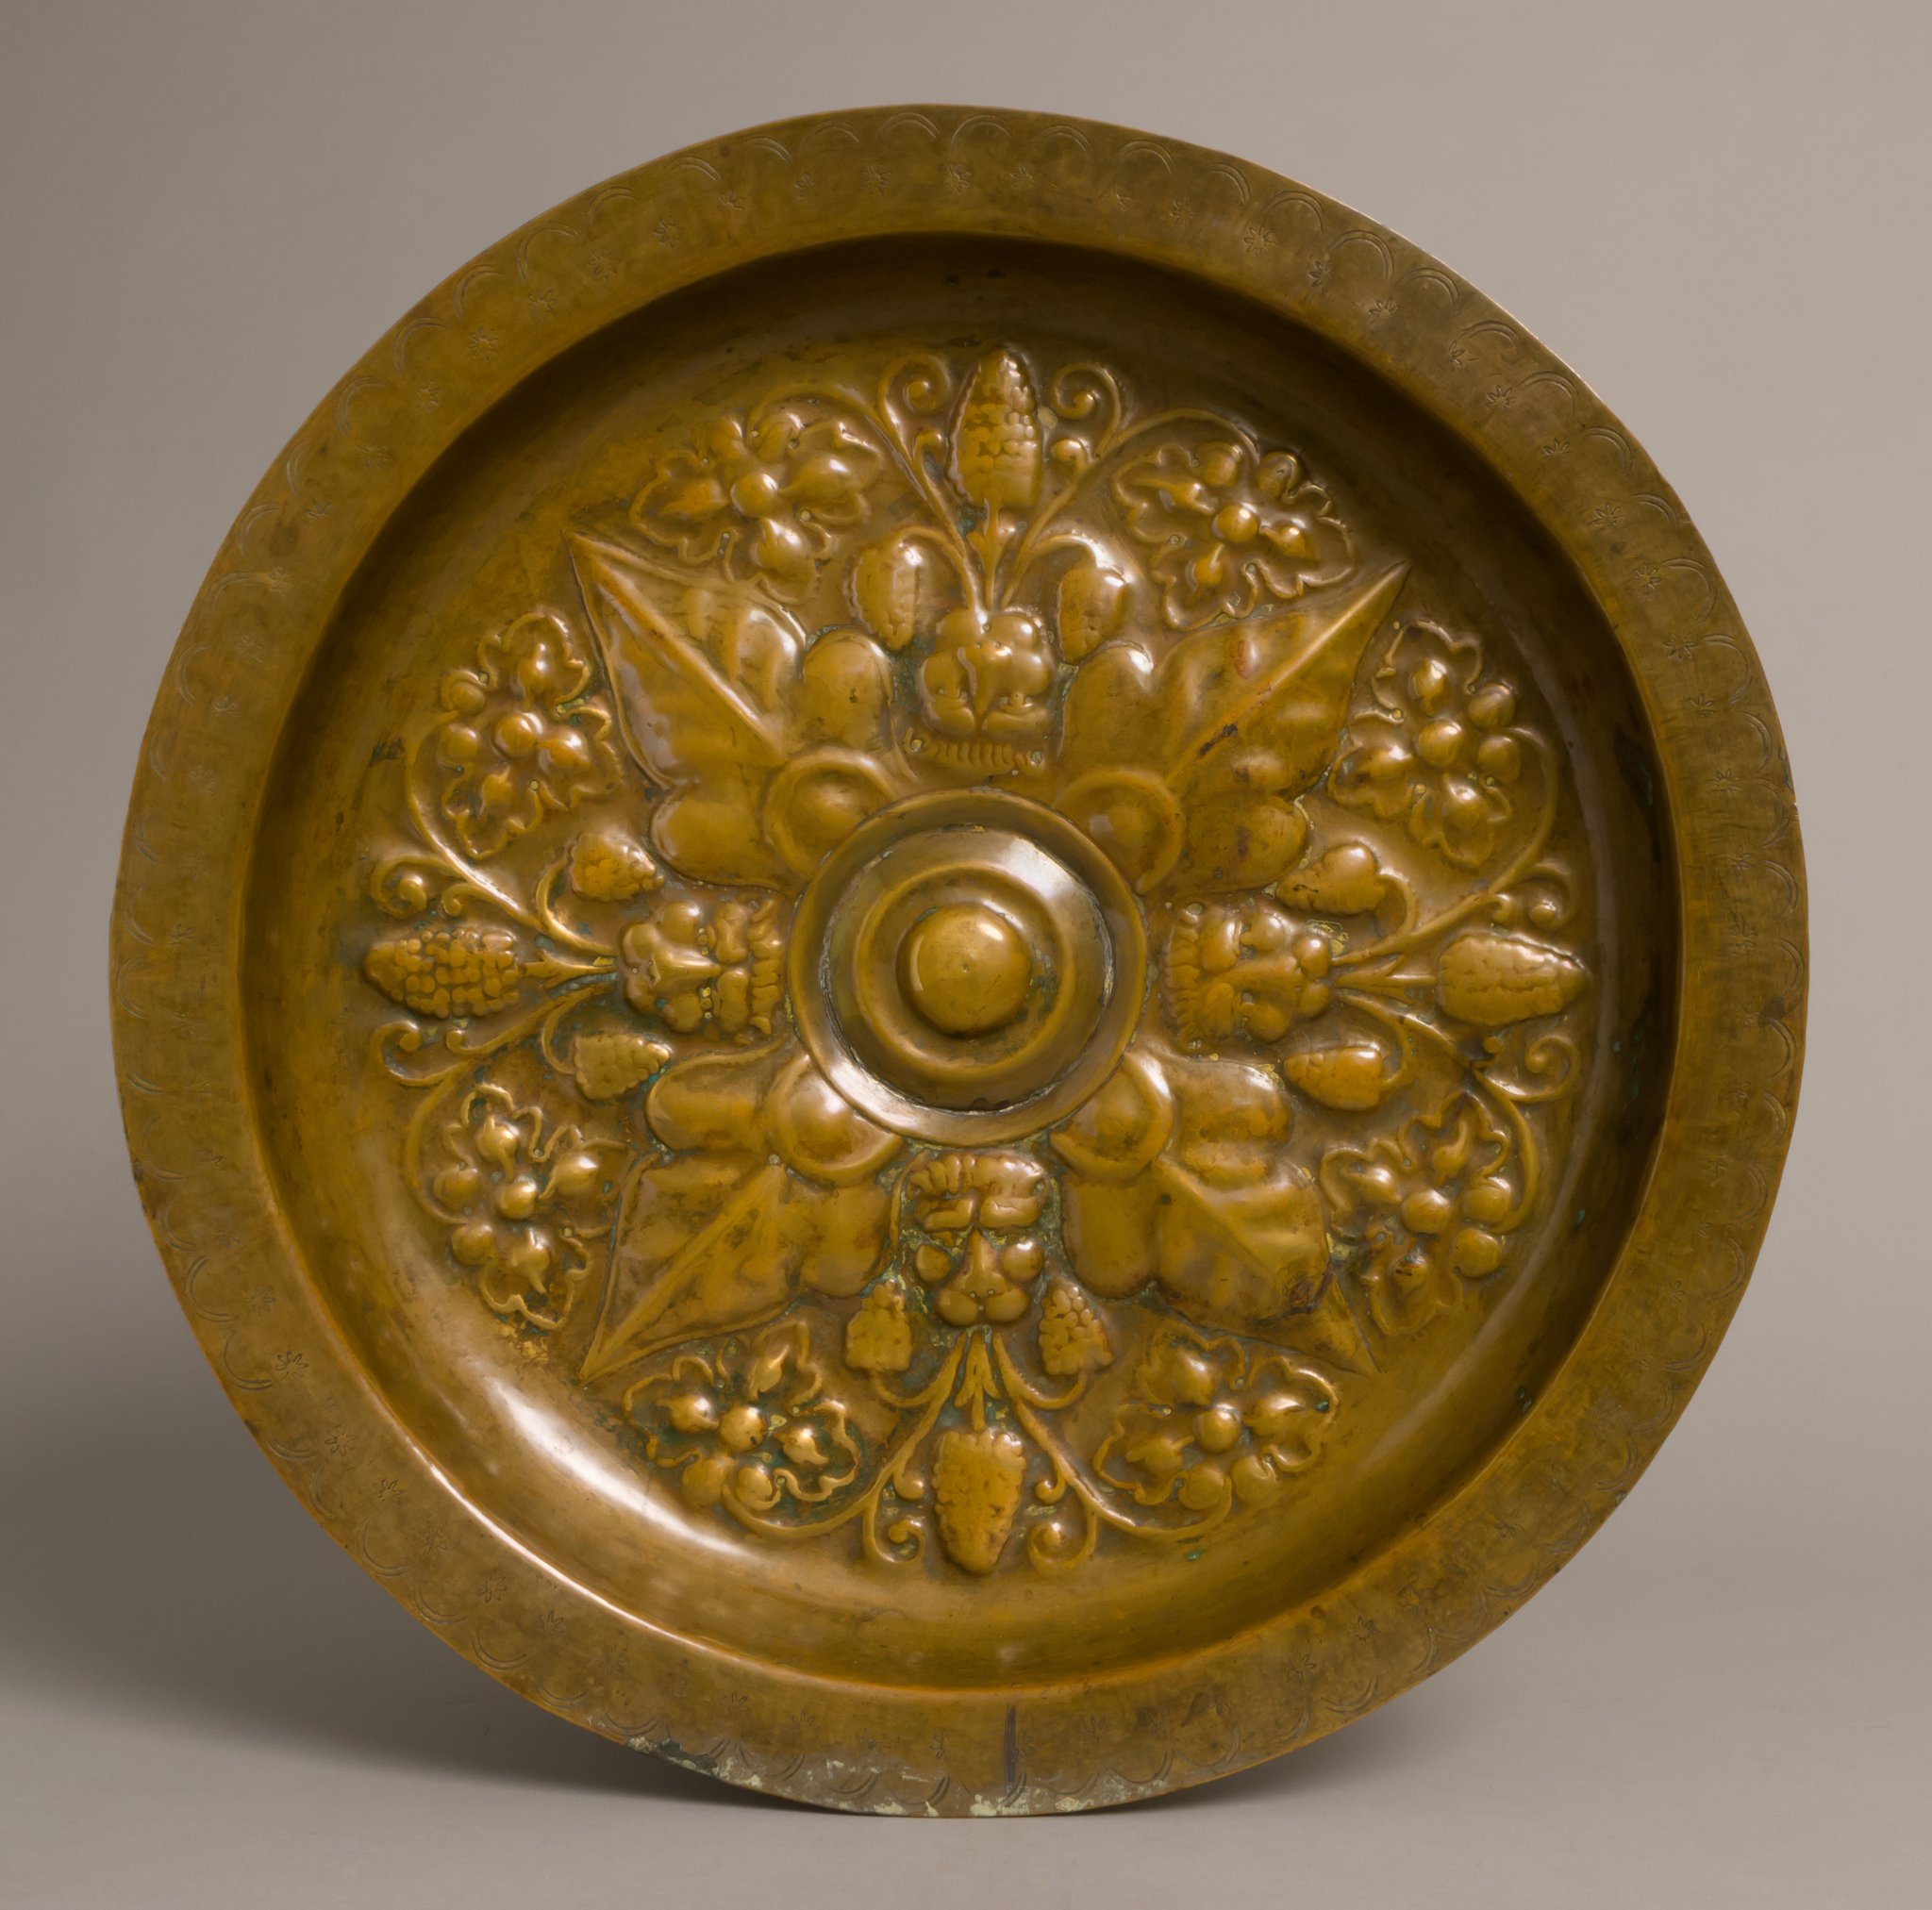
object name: plate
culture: german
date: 1467-1500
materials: brass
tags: flowers